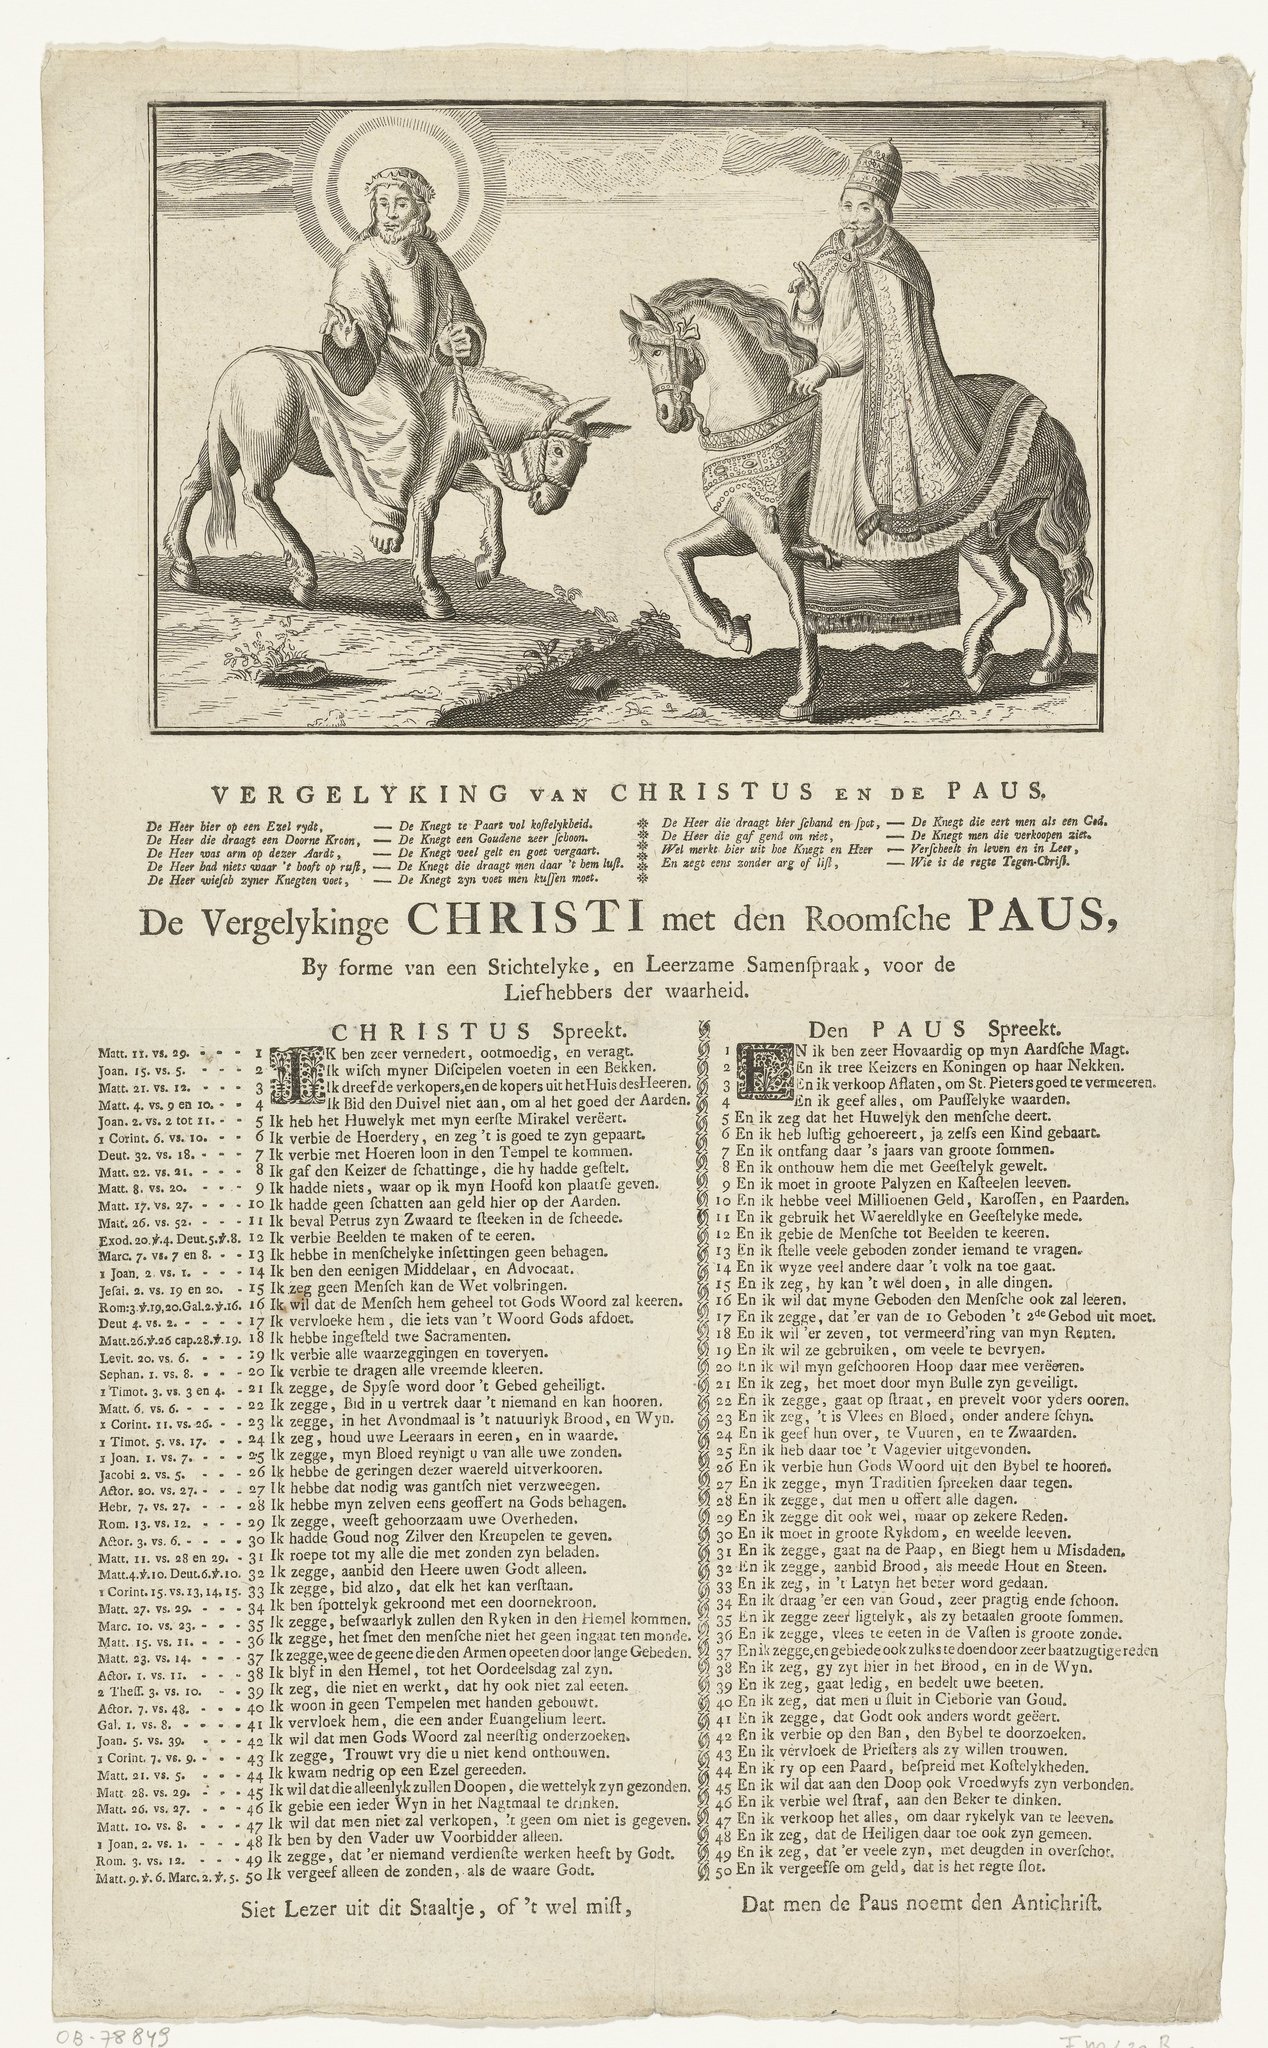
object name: print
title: Christus op de ezel, de paus te paard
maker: Anonymous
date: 1750-1799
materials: paper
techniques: engraving, etching, letterpress printing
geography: northern netherlands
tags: reformation (roman catholic church vs. protestantism), the pope on horseback, and christ on an ass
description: Christus op de ezel, de paus te paard. Vergelijking tussen de nederigheid van Christus en de hoogmoed van de paus. Met onderschriften onder de plaat van 2 keer 2 kolommen van 5 en 4 regels en van 50 genummerde verschillen tussen Christus en de paus in het Nederlands op het blad. Spotprent op de paus en de Roomse kerk, waarin gebruikt wordt gemaakt van een oorspronkelijk zestiende-eeuws beeldmotief.